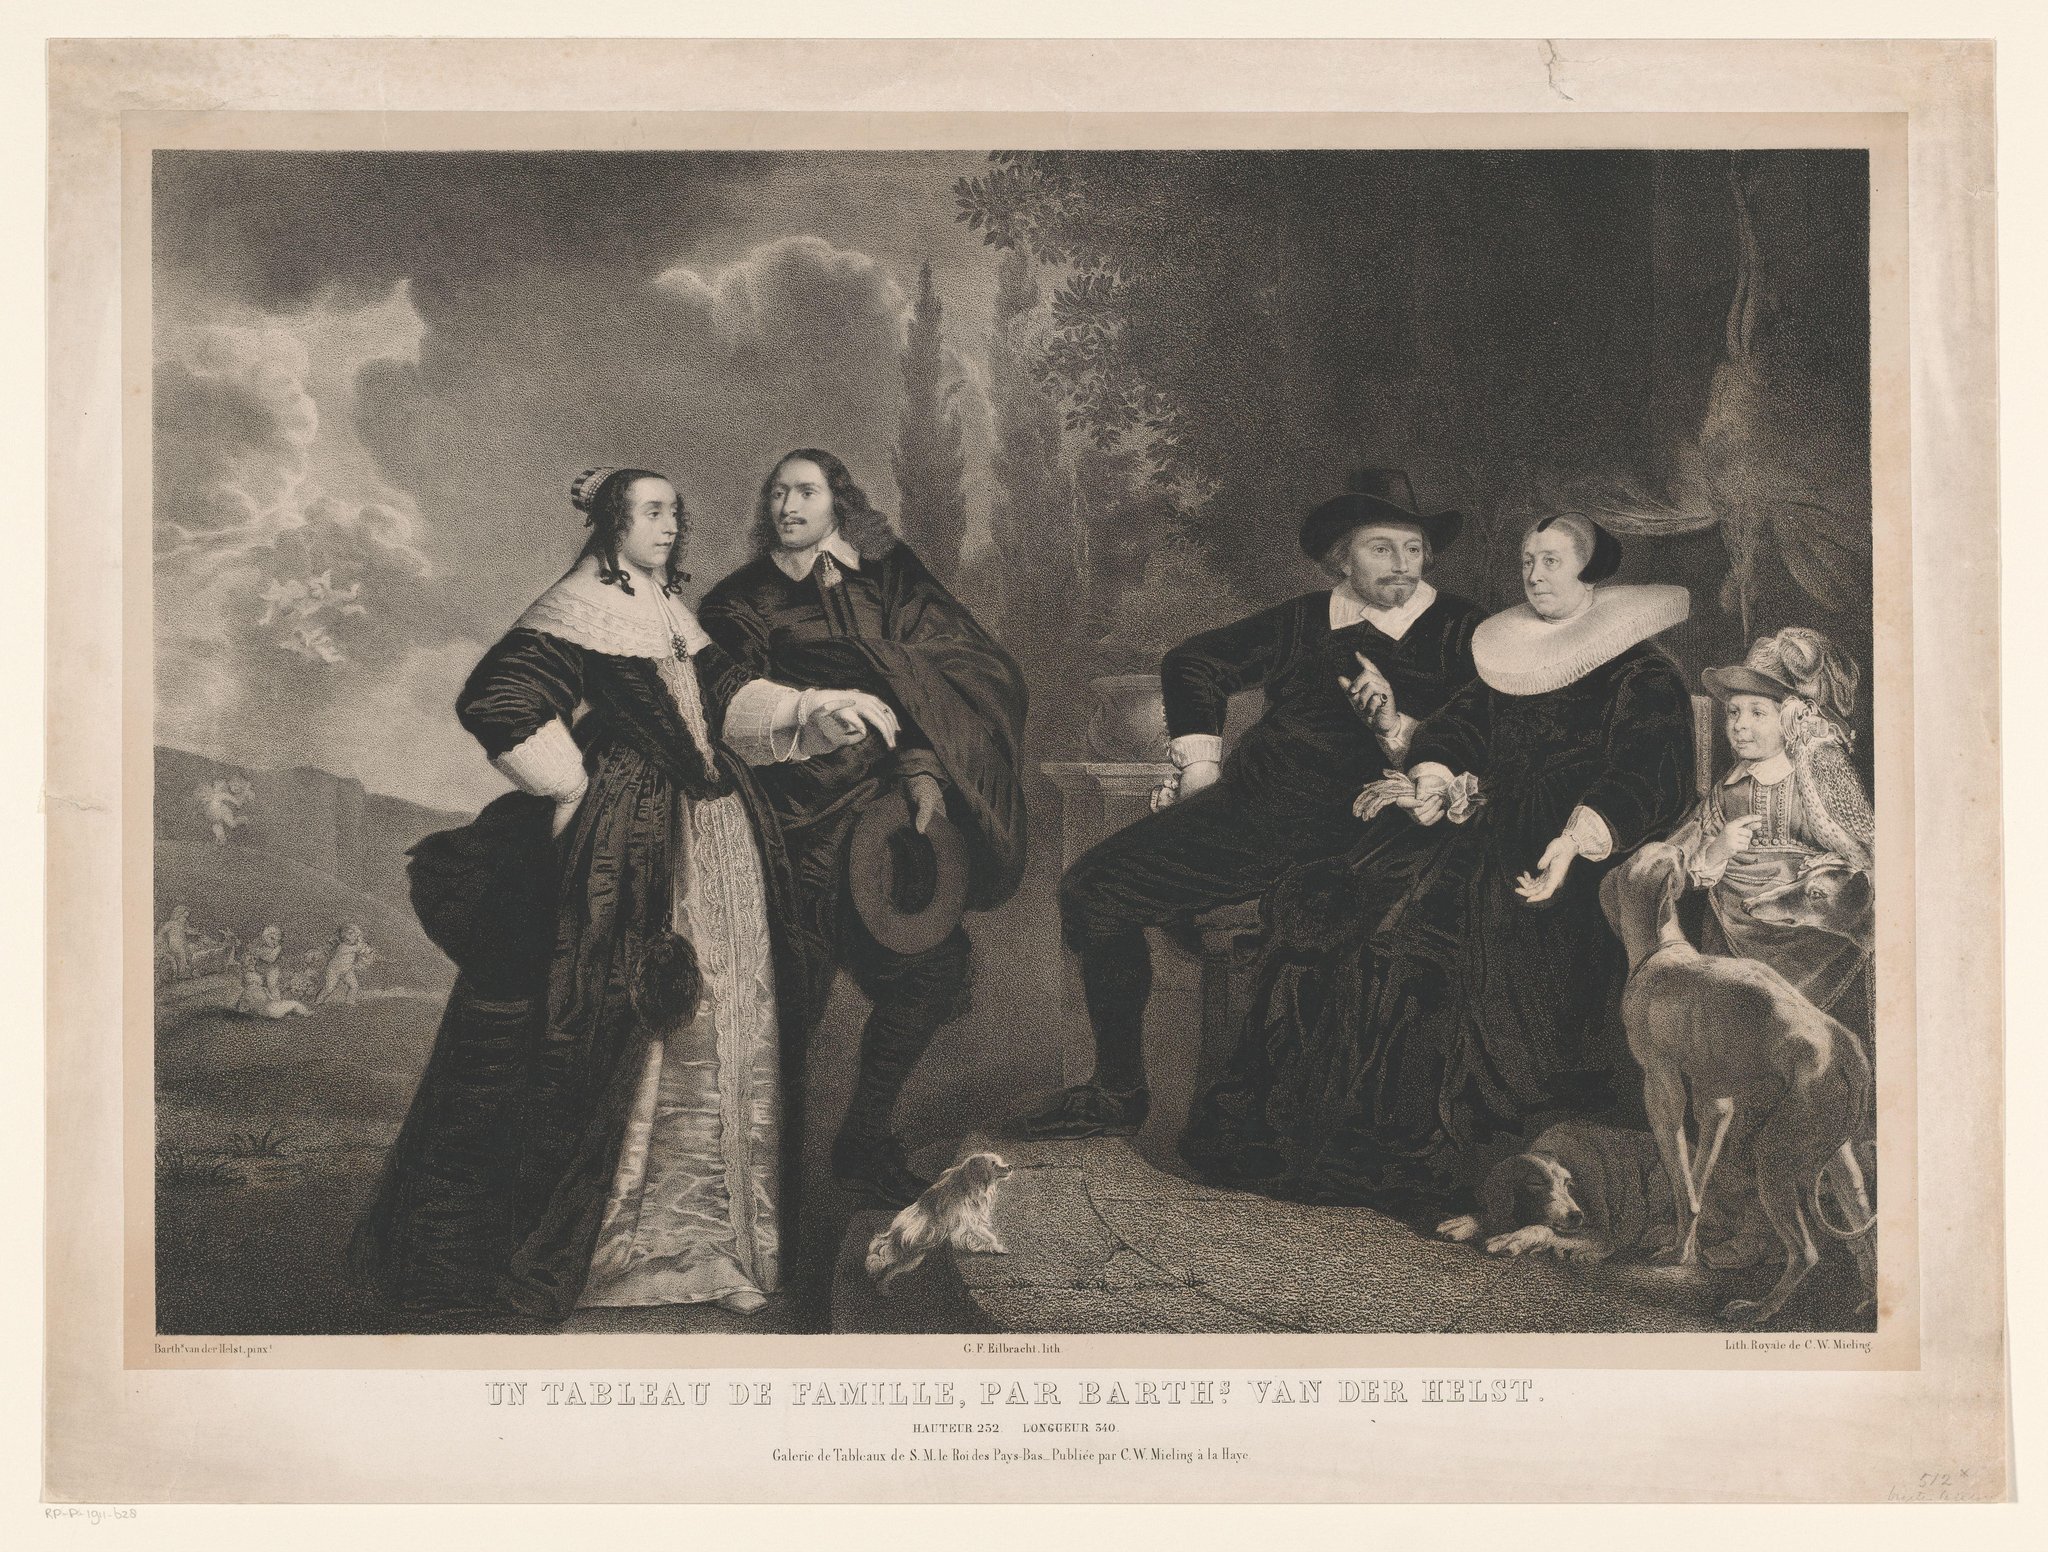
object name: print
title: Familieportret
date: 1847-1854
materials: paper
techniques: lithograph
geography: netherlands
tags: family group, especially parents with their child(ren)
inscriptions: collector's mark: Lugt 2228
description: Rechts zitten een man en vrouw, mogelijk Willem Visch met zijn vrouw Eva Bisschop. Naast hen staat een jongen met jachtvalk en jachthonden (mogelijk Willem Prins). Tegenover het zittende paar staan een jongeman en vrouw, mogelijk hun hun dochter en schoonzoon Laurenta Visch en Adriaen Prins.